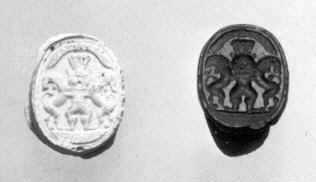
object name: stamp seal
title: Scarab seal with Bes dominating two lions below a winged sun disc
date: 600-401 BCE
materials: jasper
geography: levant or syria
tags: lions